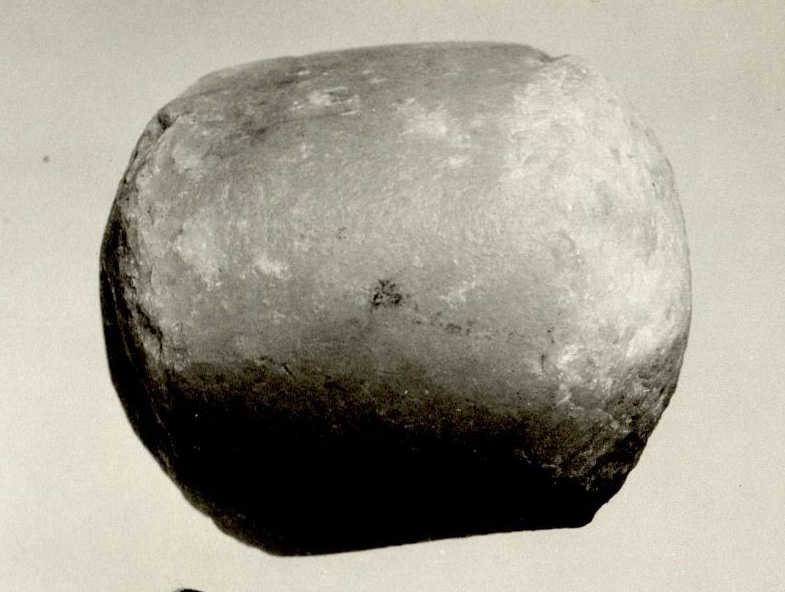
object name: pestle, pounder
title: Pounder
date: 4500-4000 BCE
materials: quartz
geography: egypt